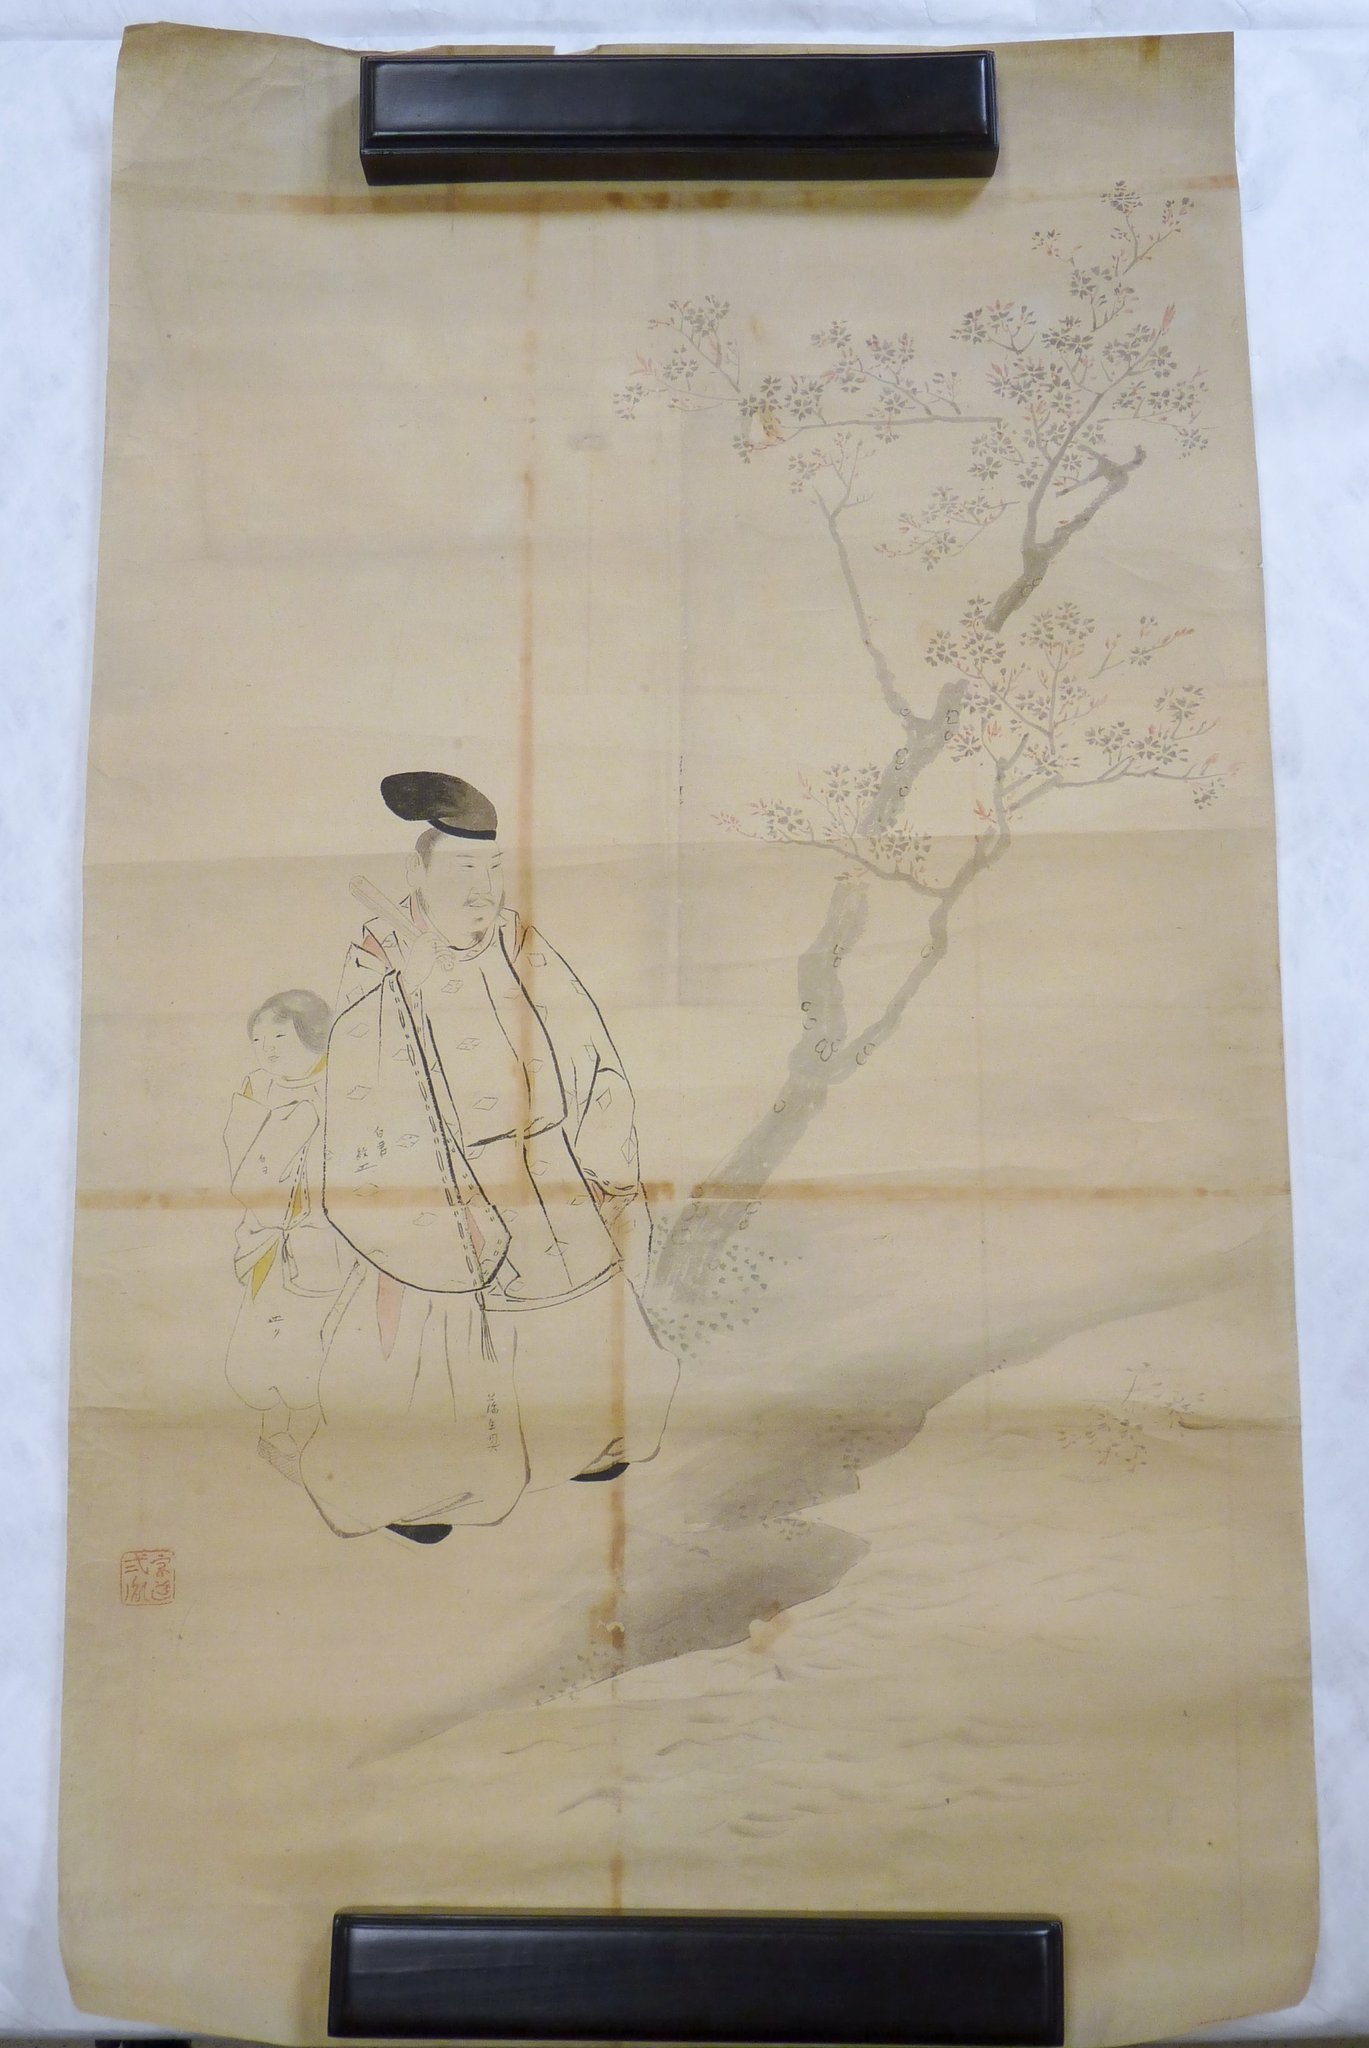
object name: drawing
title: Japanese Drawing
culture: japanese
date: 1801-1833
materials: paper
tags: trees